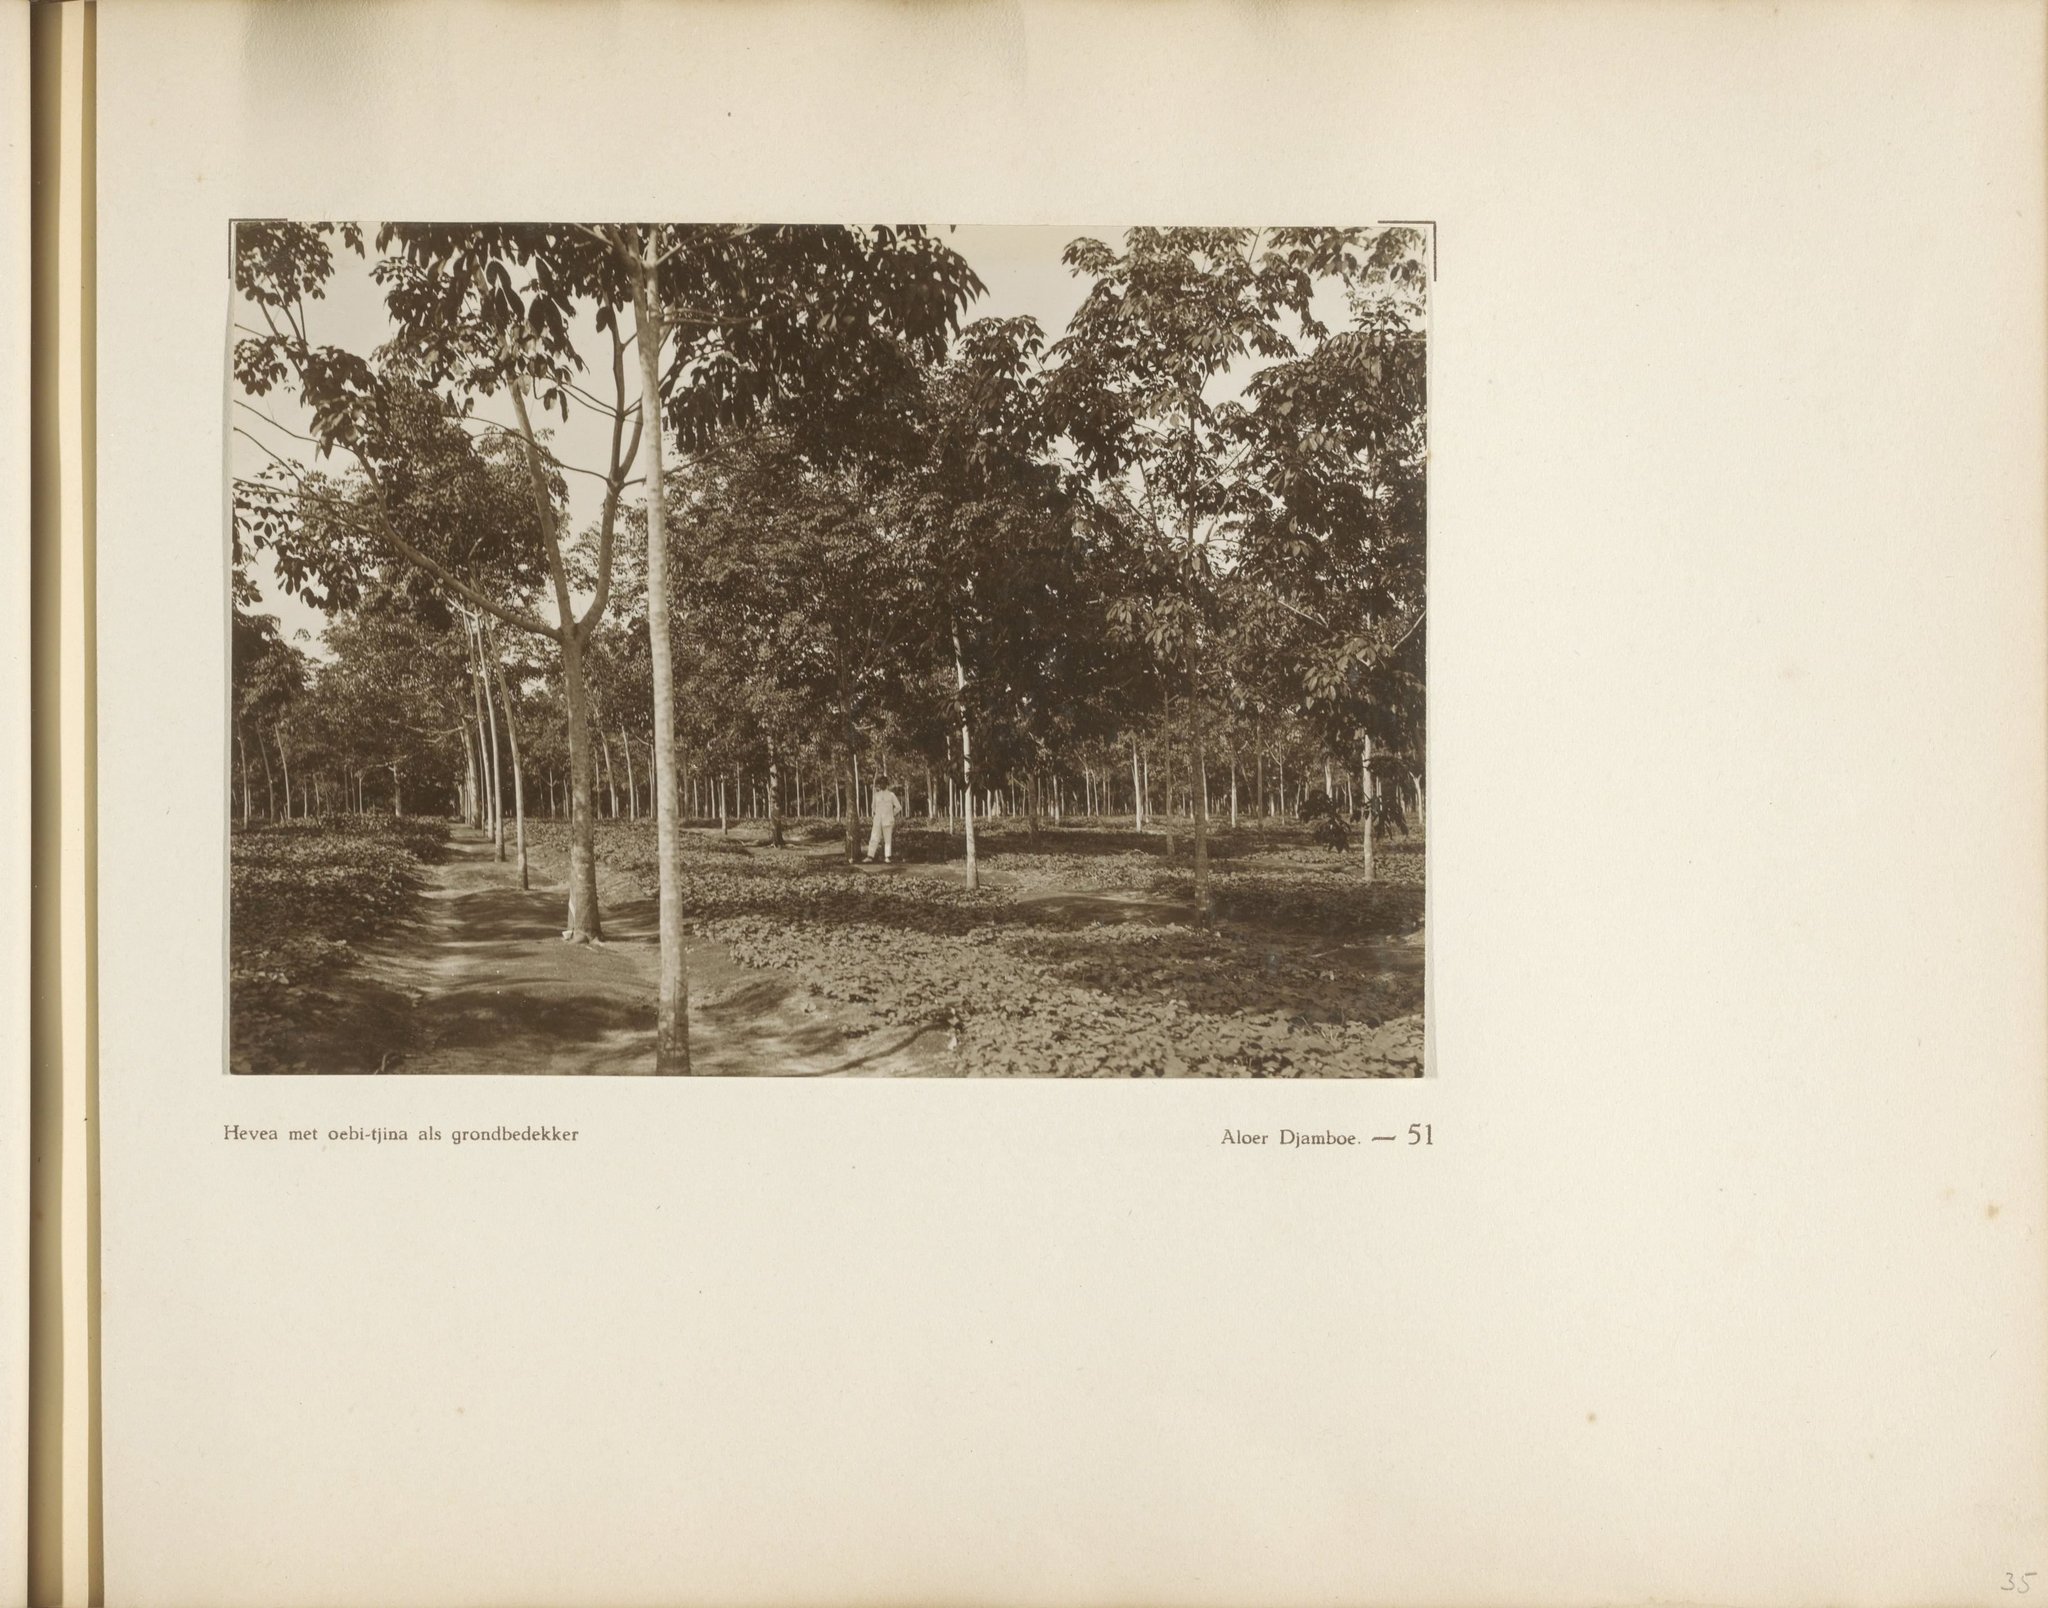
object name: photograph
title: Pagina 51 van fotoboek van de Algemeene Vereeniging van Rubberplanters ter Oostkust van Sumatra (A.V.R.O.S.)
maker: j.w. meyster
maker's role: fotograaf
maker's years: 1887-1945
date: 1924-1925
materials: paper, photographic support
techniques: printing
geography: dutch east indies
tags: plantation, (non-fruit) products of plants or trees: rubber, sumatra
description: Boekpagina met een foto van een man poserend temidden van hevea-aanplant te Aloer Djamboe. Onderdeel van een fotoboek van de Algemeene Vereeniging van Rubberplanters ter Oostkust van Sumatra (A.V.R.O.S.).